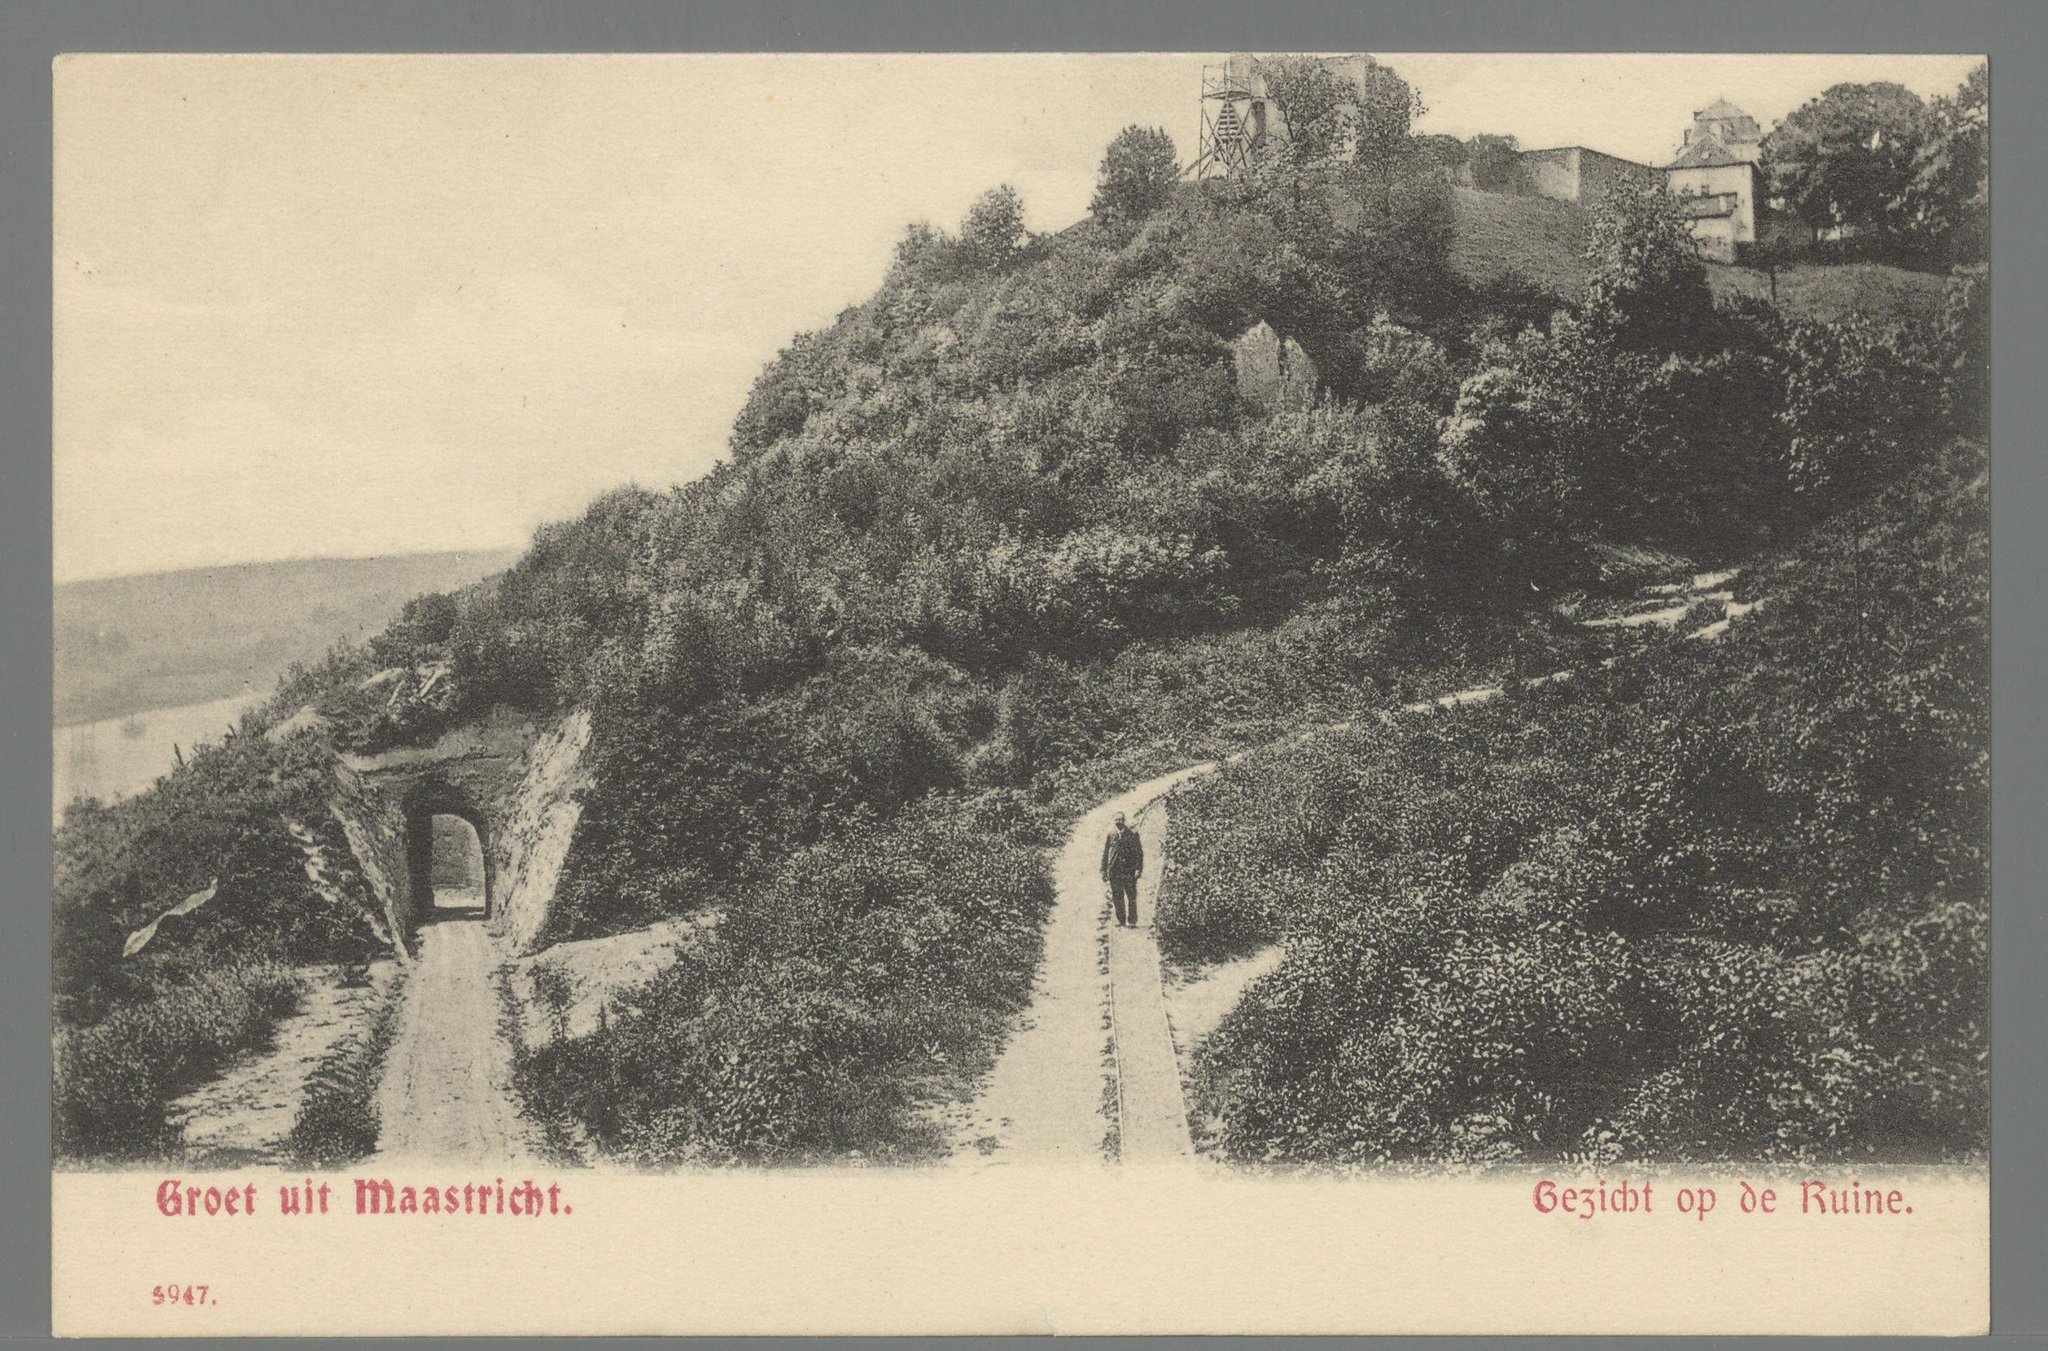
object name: photomechanical print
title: Groet uit Maastricht. Gezicht op de Ruine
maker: Anonymous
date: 1905-1930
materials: cardboard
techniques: photograph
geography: sint-pietersberg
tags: ruin of a dwelling, house, castle, etc., mountains